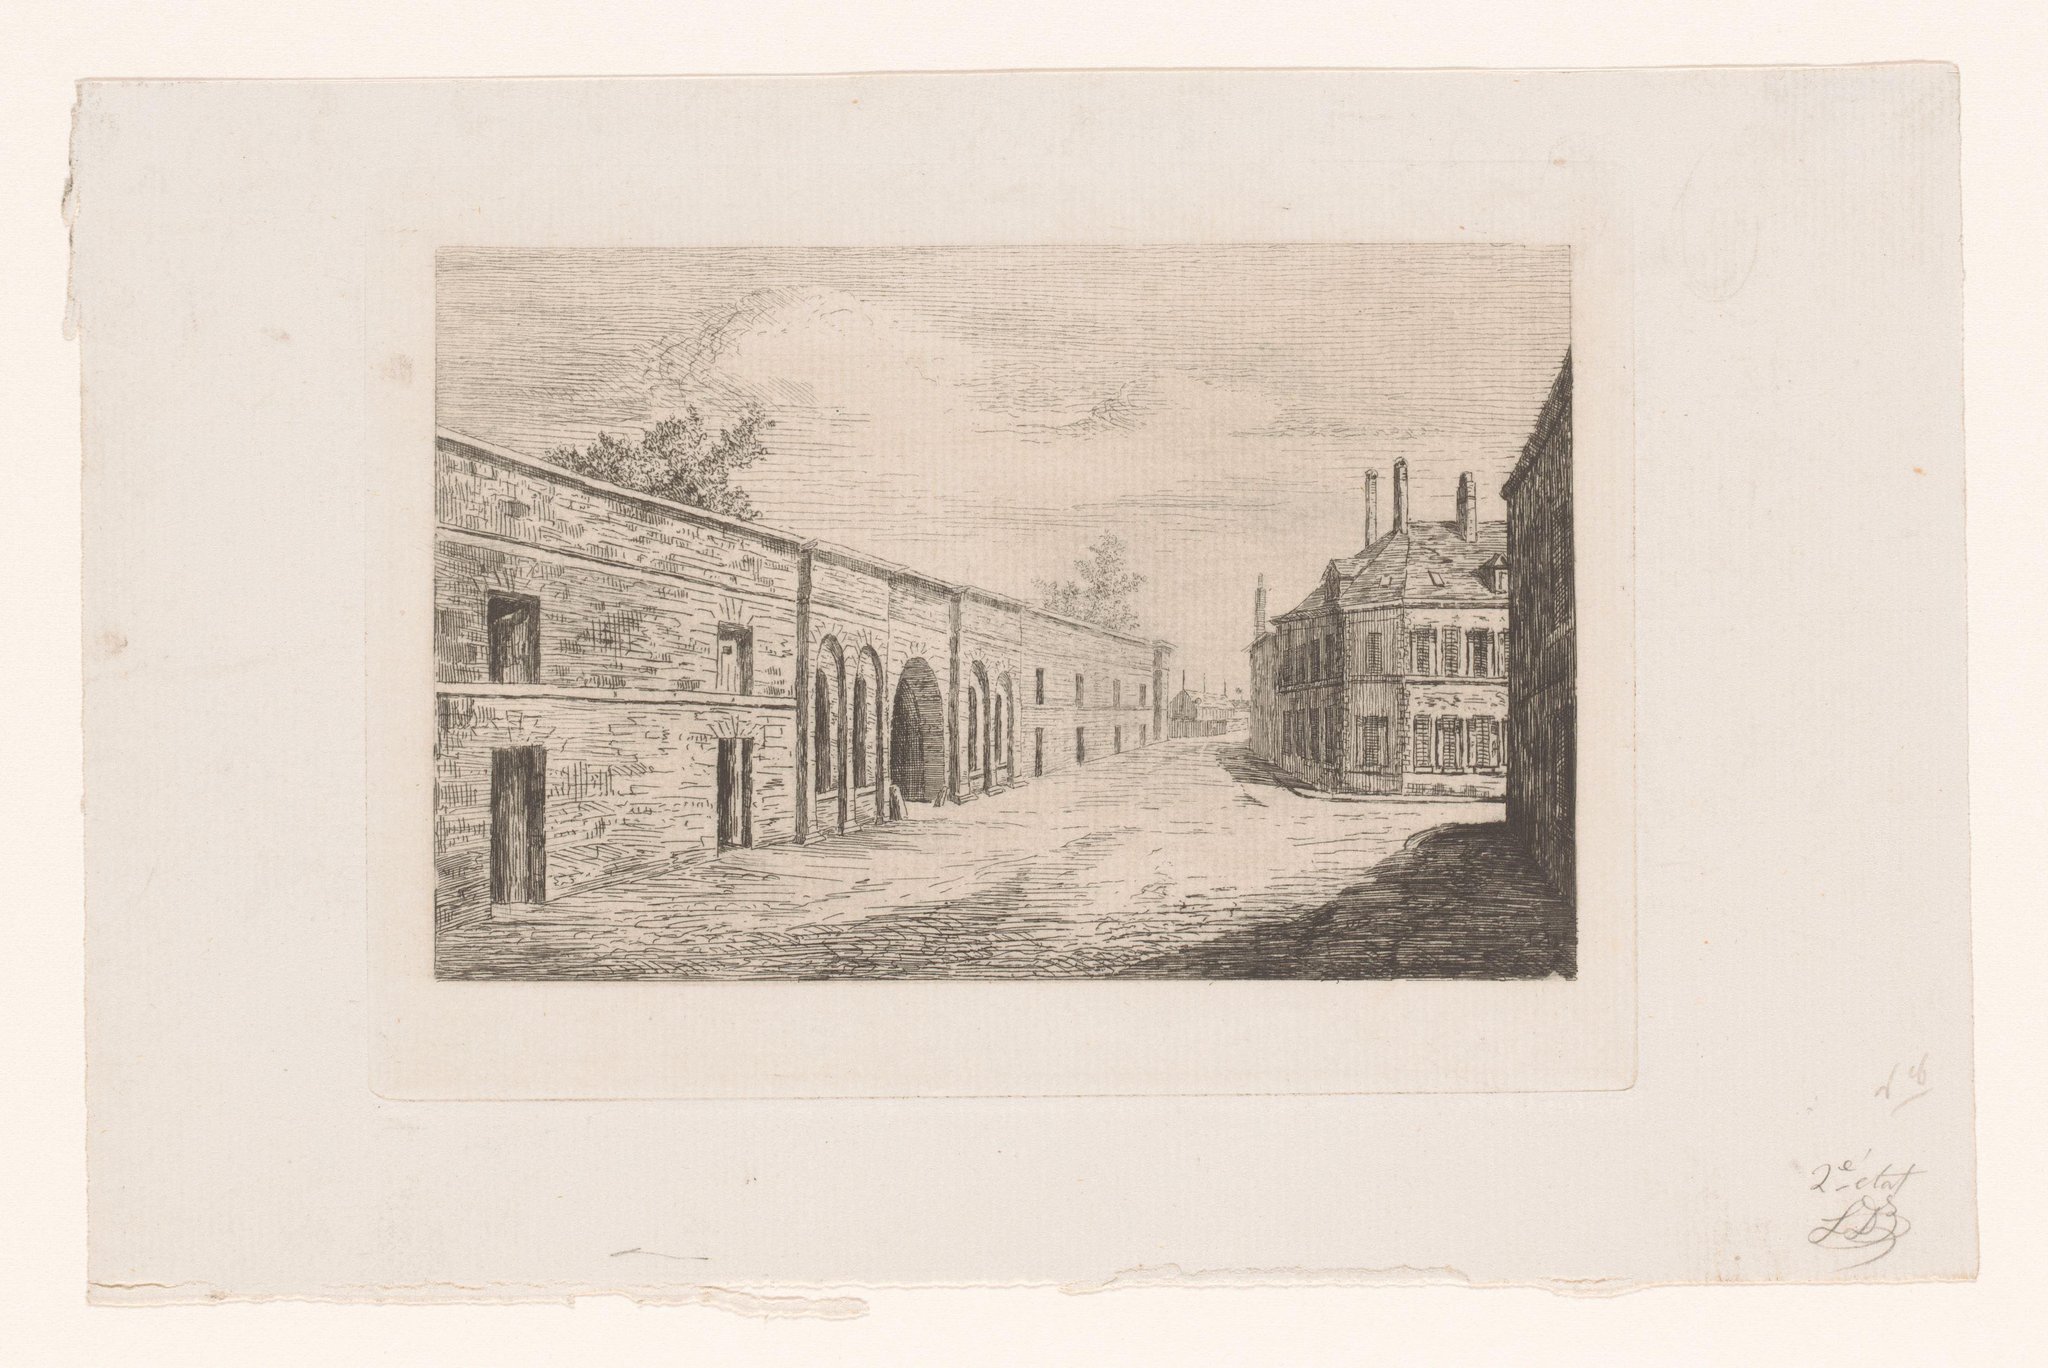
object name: print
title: Vestingwerken van Mons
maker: léon dolez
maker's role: print maker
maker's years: 1837-1902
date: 1875-1878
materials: paper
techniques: drypoint, etching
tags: village-gate, street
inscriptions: collector's mark: Lugt 2228, inscription: ‘2e état’